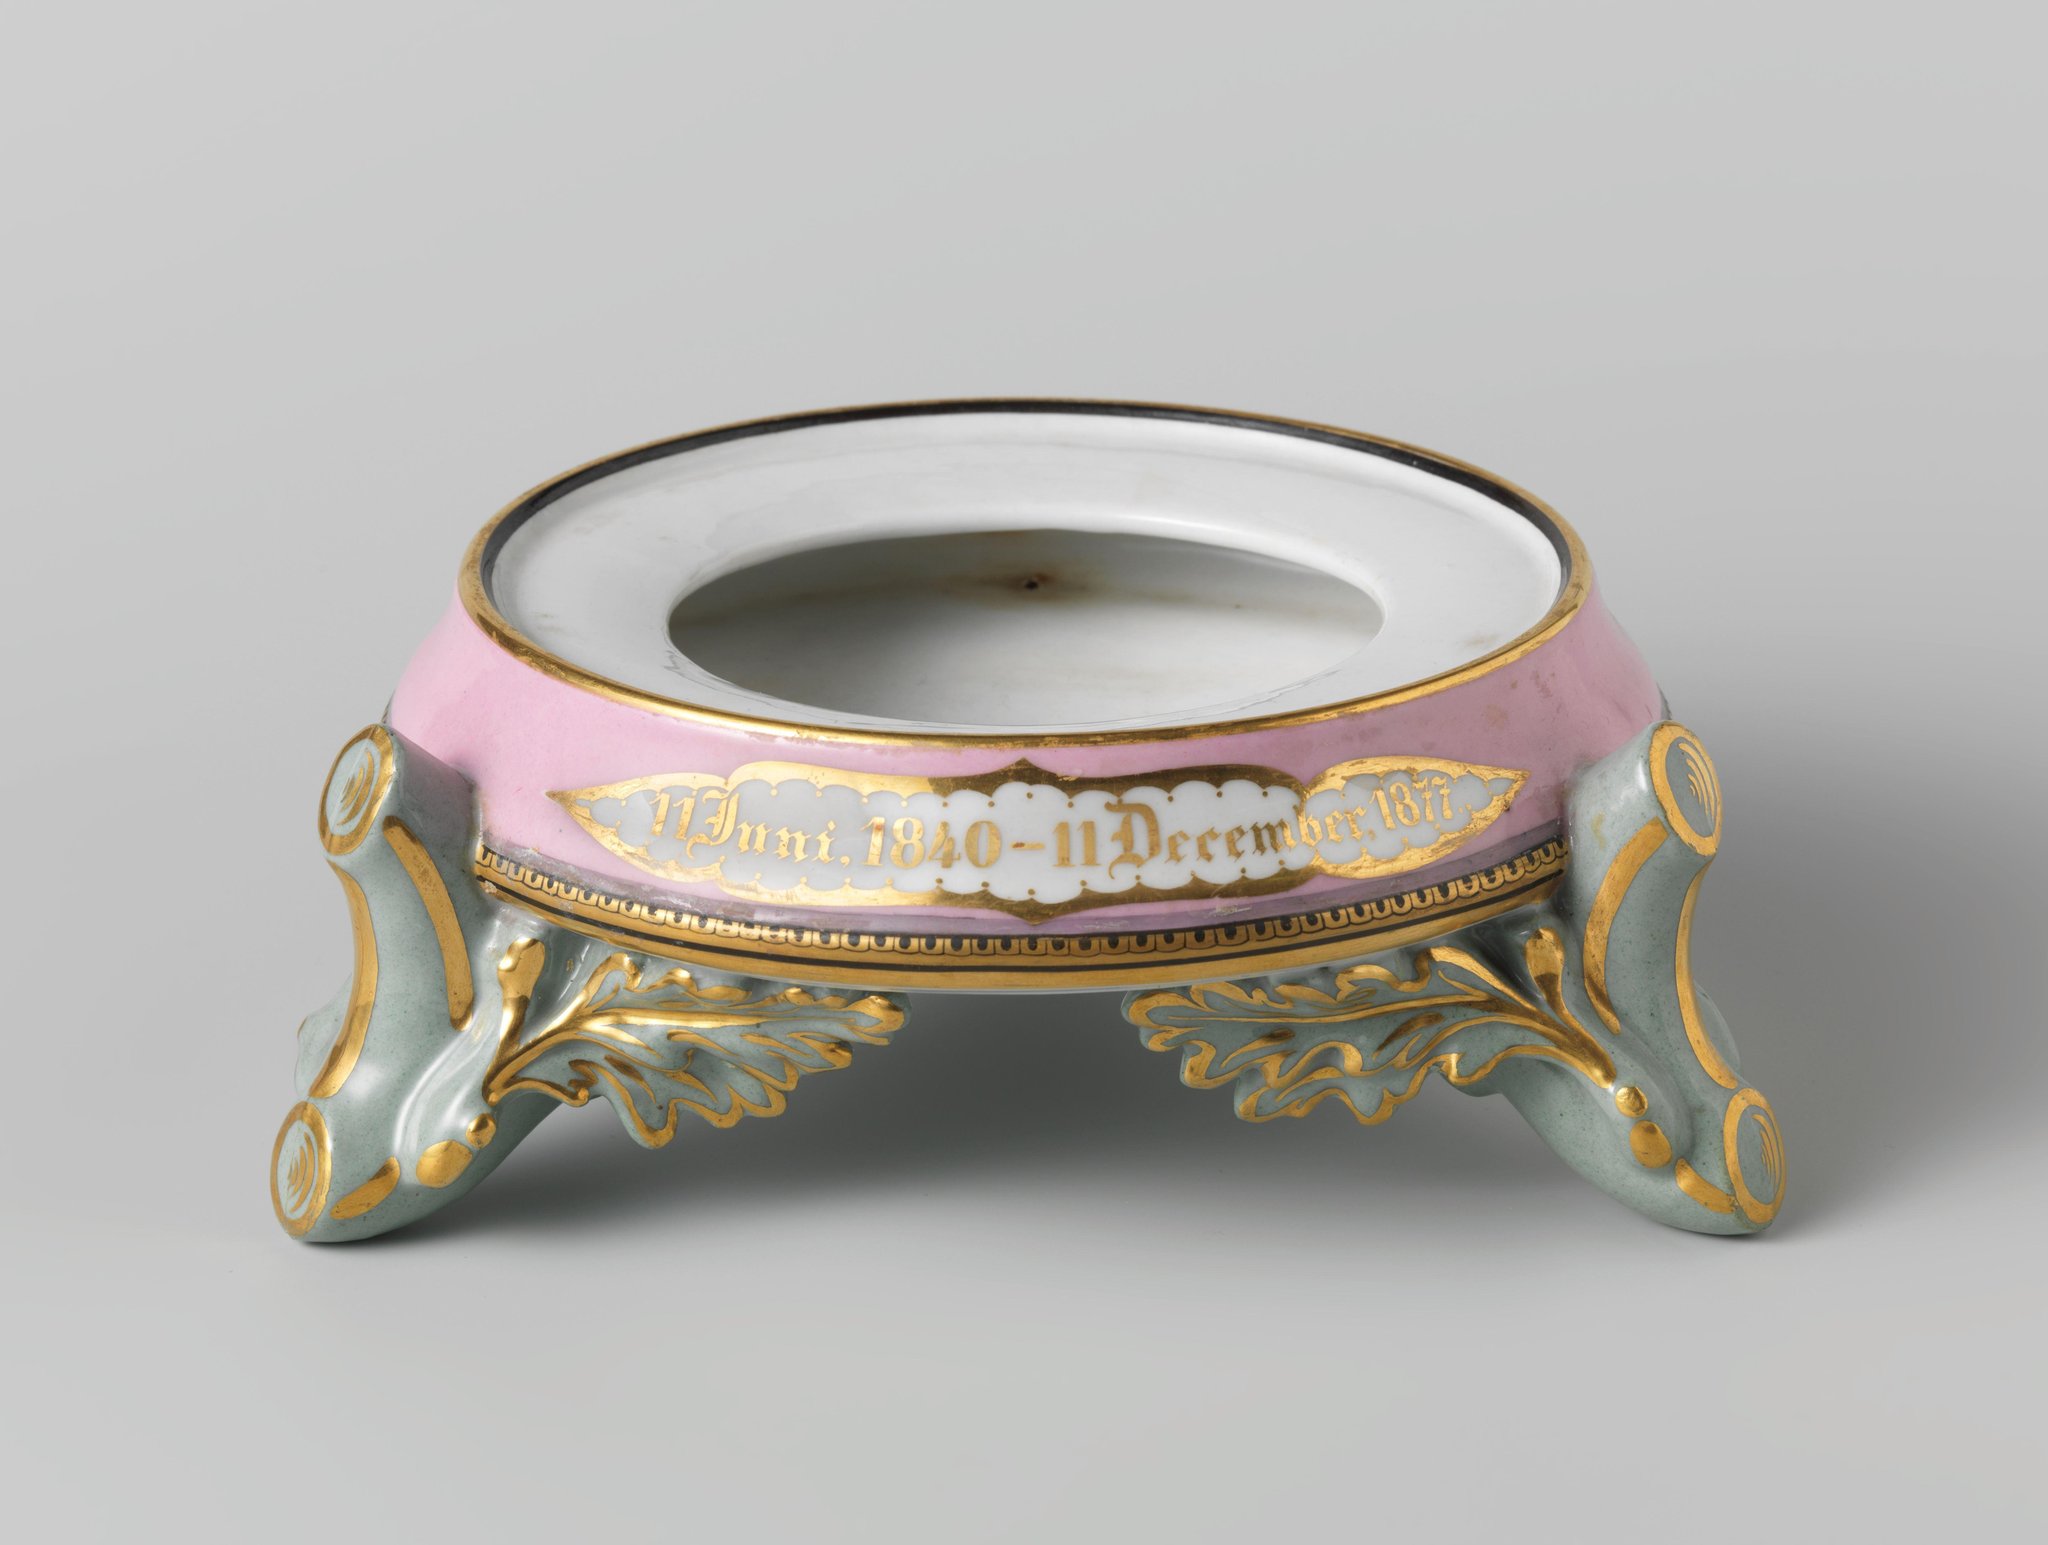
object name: cachepot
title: Voet van cachepot met drie portretten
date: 1877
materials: porcelain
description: Voet van cachepot op drie pootjes. Opschrift: 11 Juni 1840 -11 December 1877.